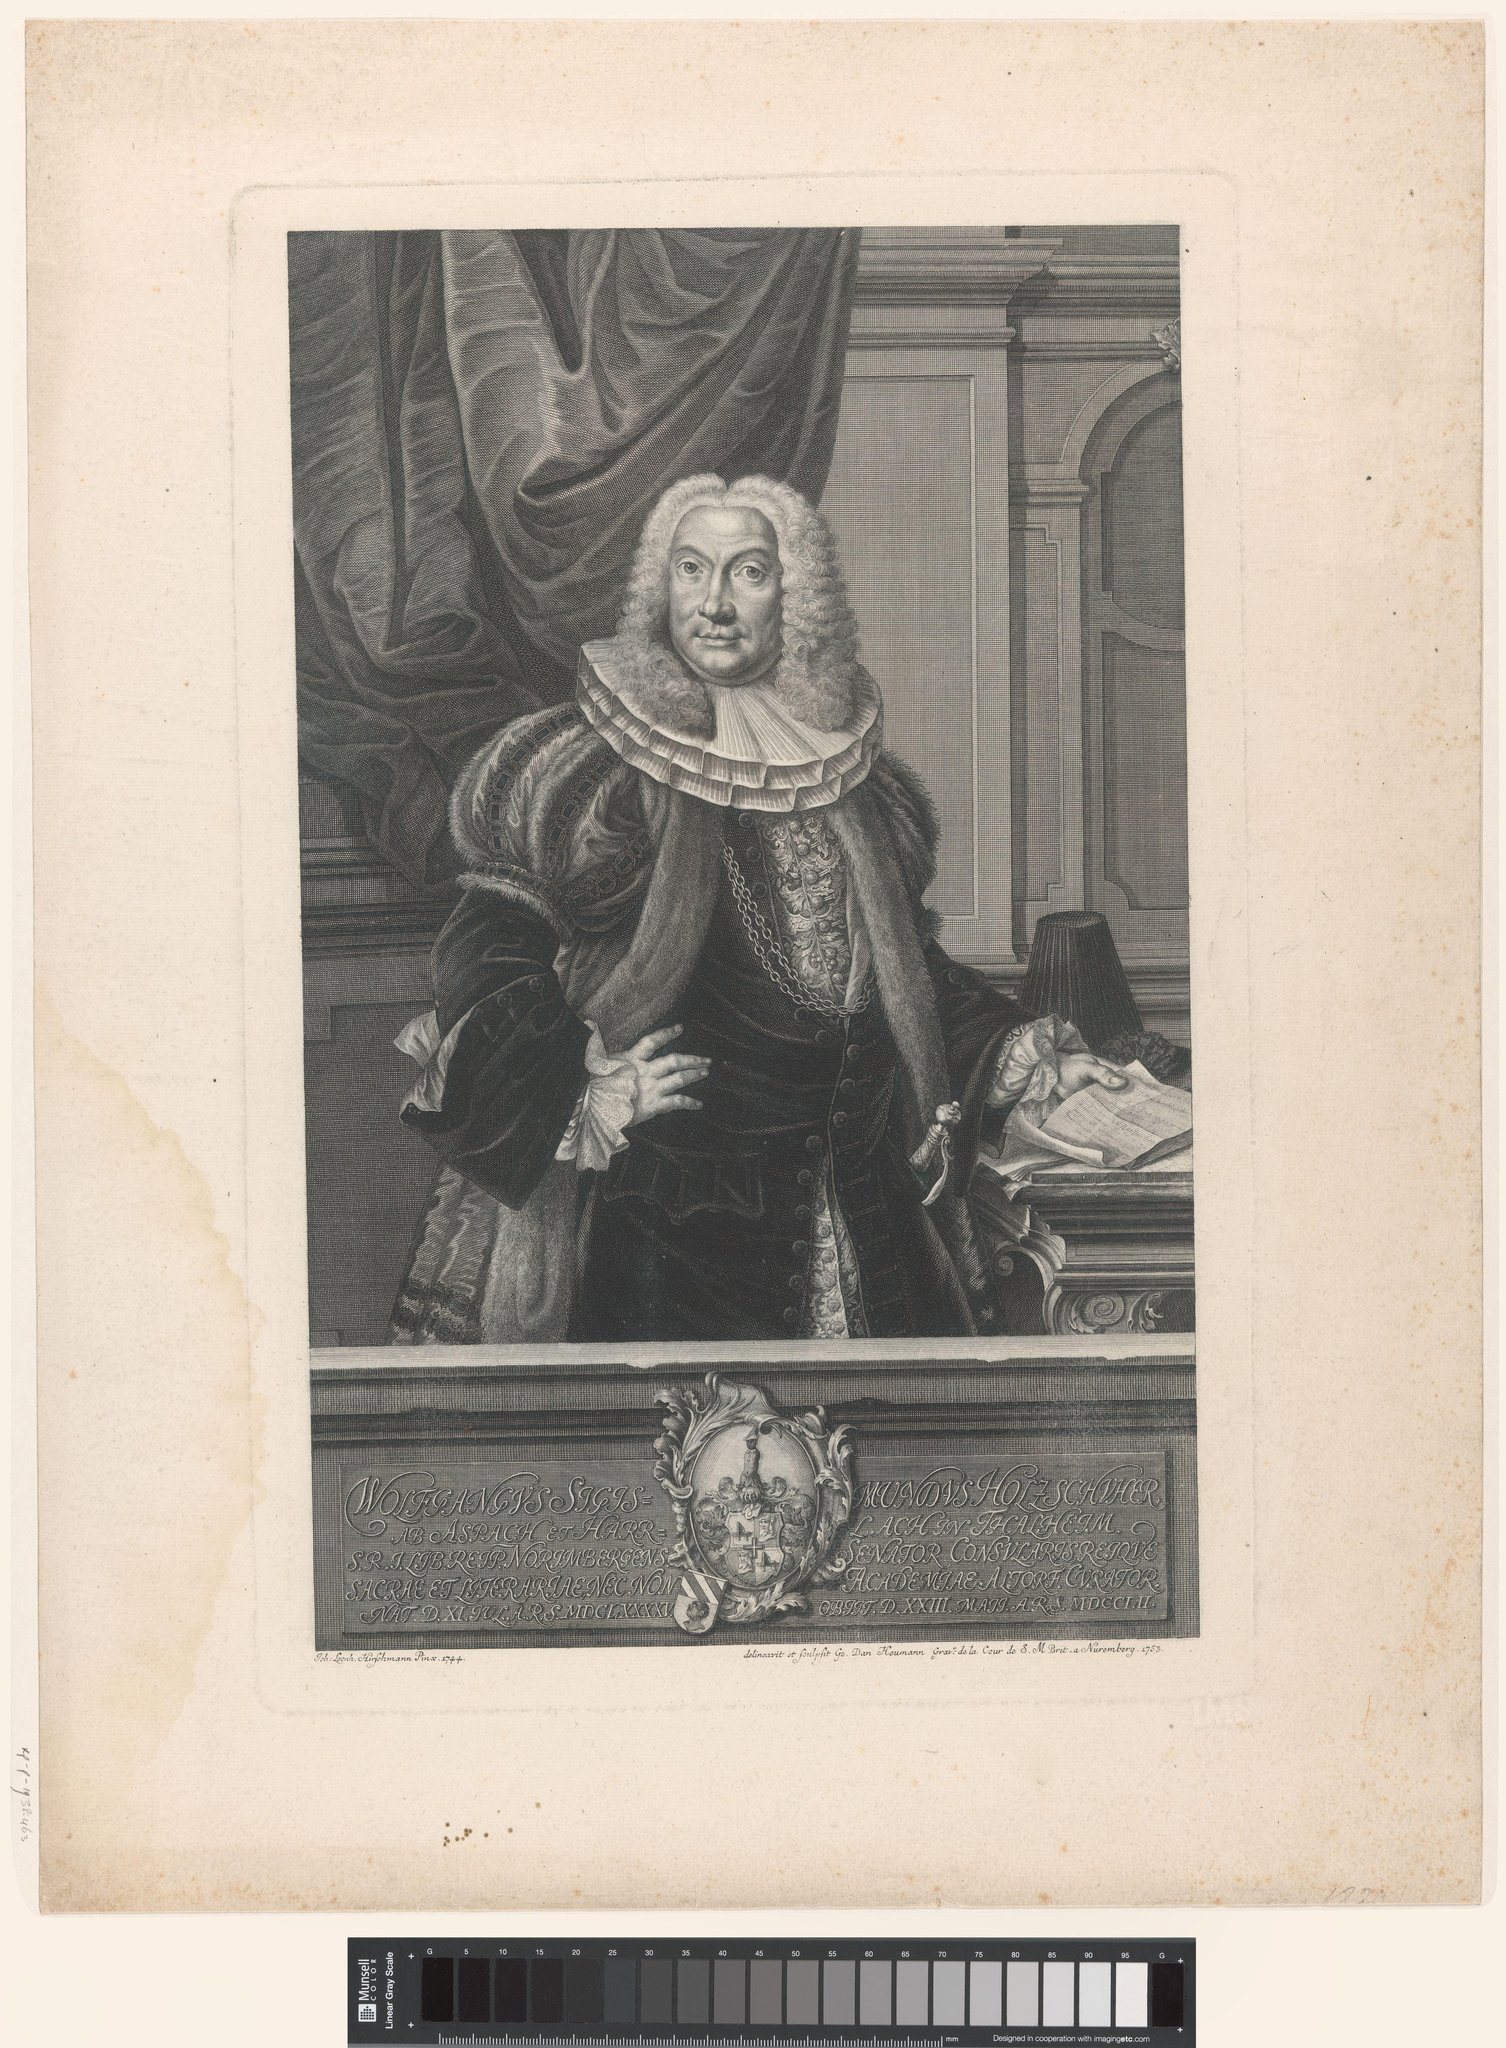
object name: print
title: Portret van Wolfgang Sigismund Holzschuher von Aspach und Harrlach auf Thalheim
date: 1753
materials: paper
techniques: engraving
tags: historical persons, armorial bearing, heraldry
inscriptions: collector's mark: Lugt 2228, collector's mark: Lugt 1496c